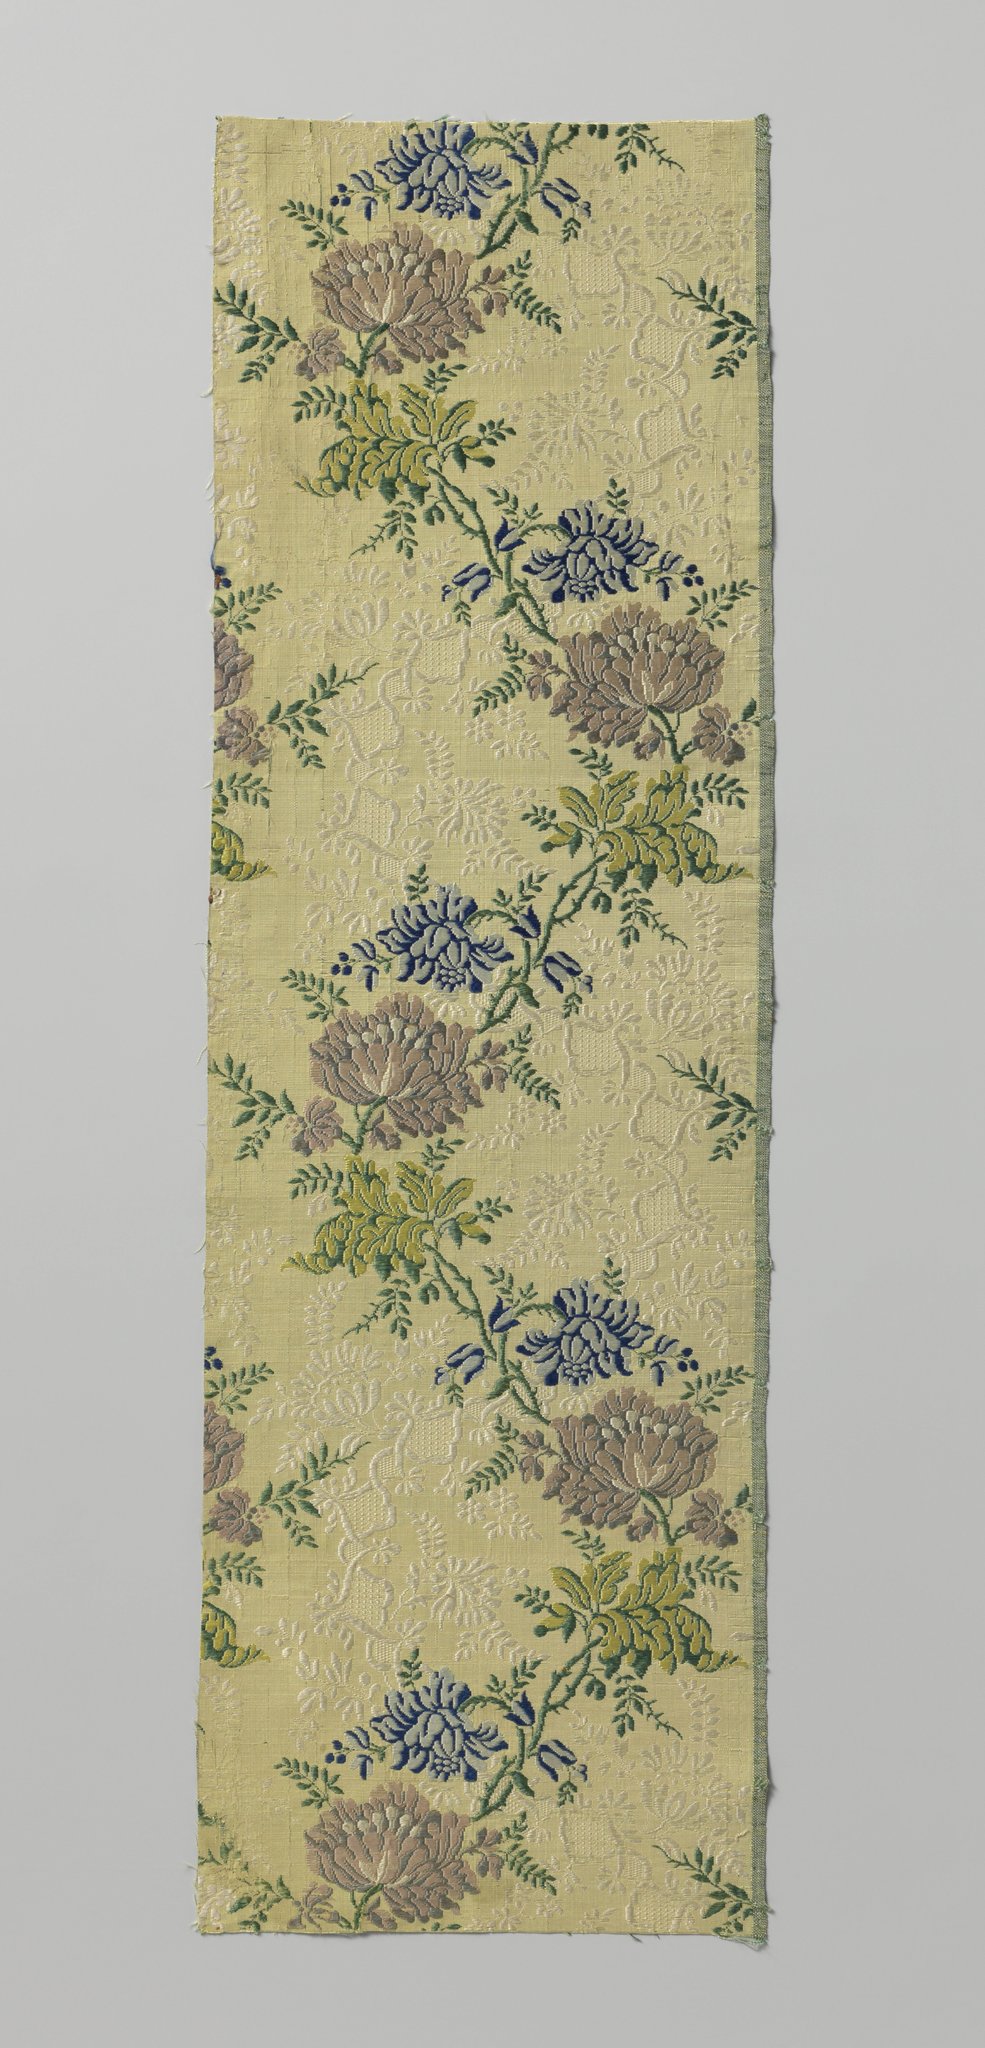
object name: fragment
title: Fragment veelkleurige gebrocheerde zijde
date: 1700-1760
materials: silk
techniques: brocade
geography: netherlands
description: Fragment veelkleurig zijdeweefsel. Op een gele grond loopt een witte slingerende kantstrook die een slingerende strook veelkleurige bloemtakken kruist.